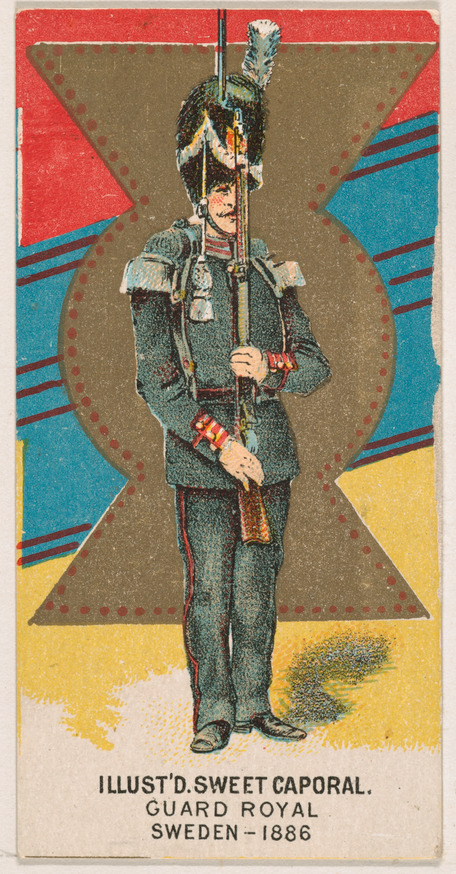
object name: print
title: Royal Guard, Sweden, 1886, from the Military Series (N224) issued by Kinney Tobacco Company to promote Sweet Caporal Cigarettes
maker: kinney brothers tobacco company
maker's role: publisher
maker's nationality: american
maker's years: 1869-2011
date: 1888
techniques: color lithograph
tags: military,firearms,men